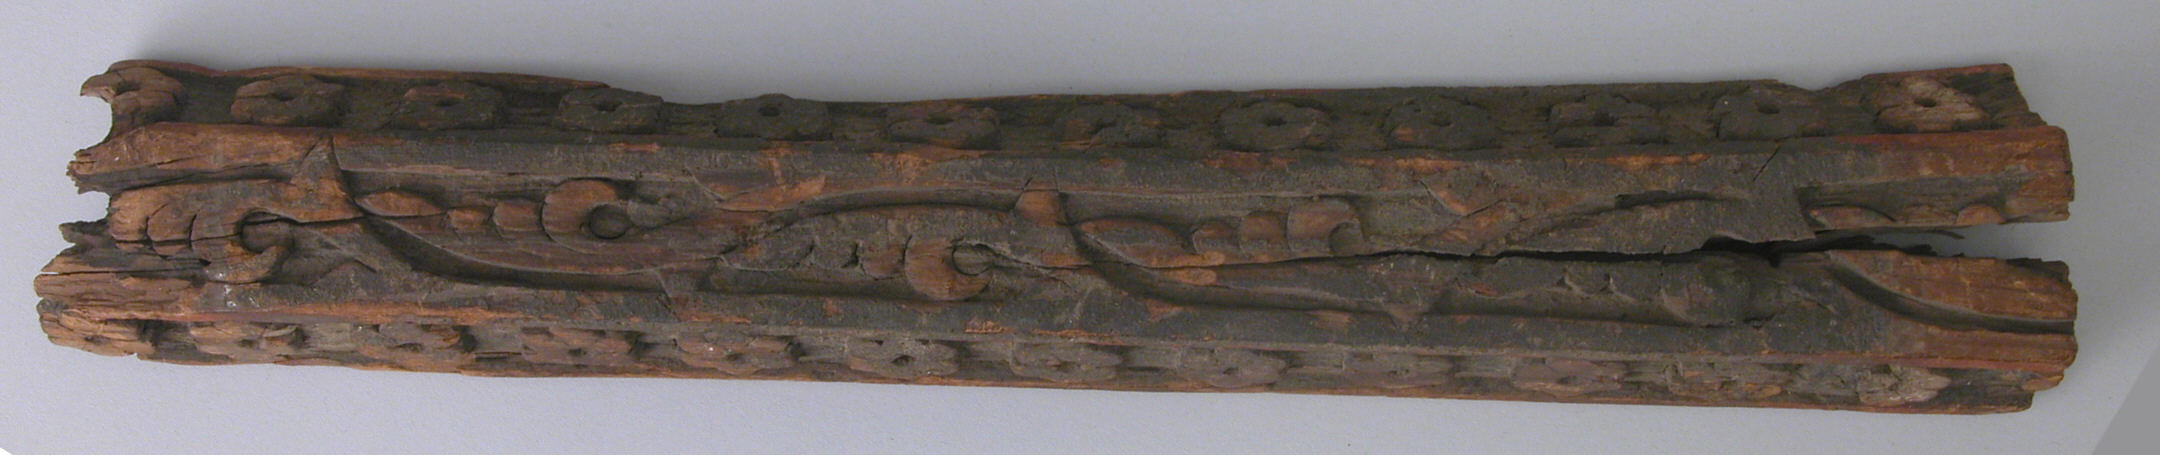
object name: wood fragment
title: Fragment of Border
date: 1301-1400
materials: wood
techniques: carving, painting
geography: spain